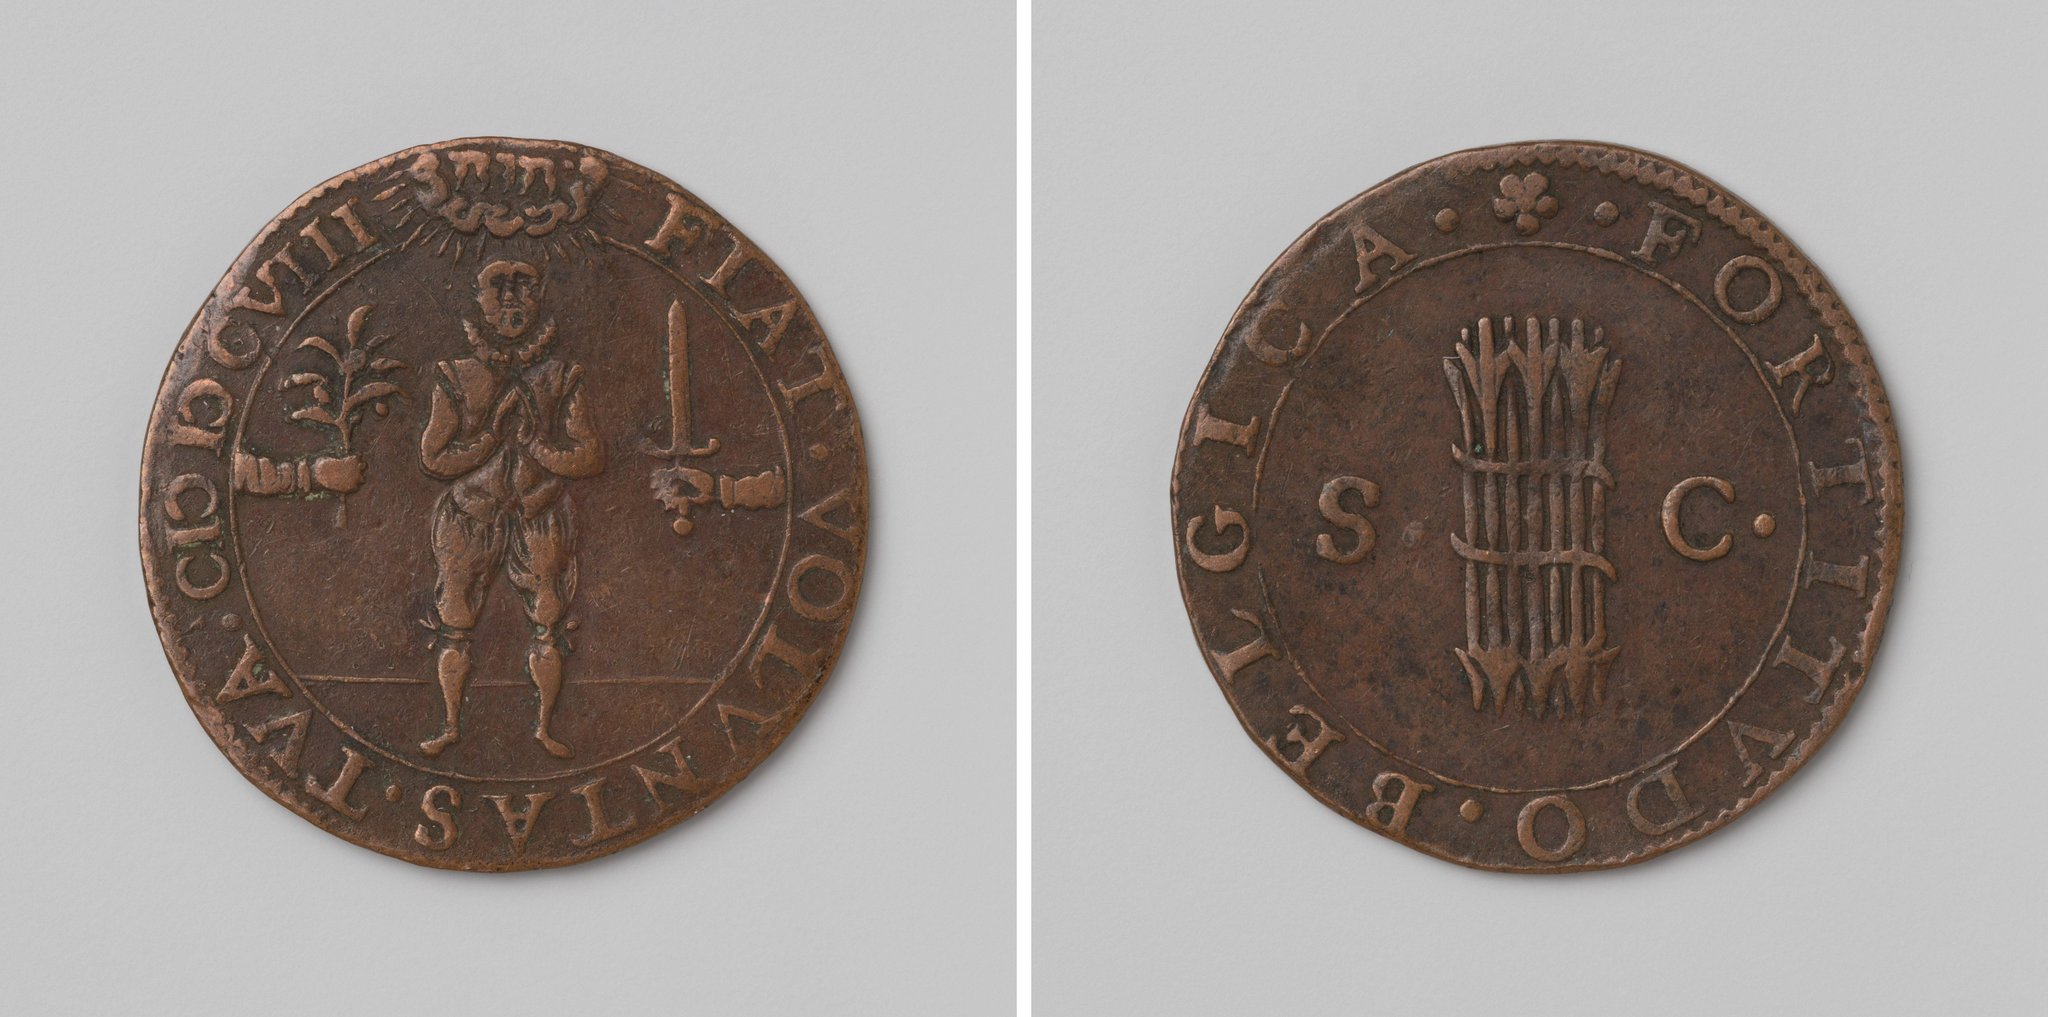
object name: jeton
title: Algemene gebedsdag bij de aanvang van de onderhandelingen te 's-Gravenhage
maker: Anonymous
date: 1608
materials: copper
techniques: striking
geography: dordrecht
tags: the hague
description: Koperen penning. Voorzijde: biddende man met gevouwen handen en blik omhoog gewend, waar naam Jehova in Hebreeuws in wolk geschreven staat; links hand die olijftak aanbiedt, rechts hand die zwaard toont binnen omschrift. Keerzijde: bundel van zeven pijlen geflankeerd door letters S en C binnen omschrift